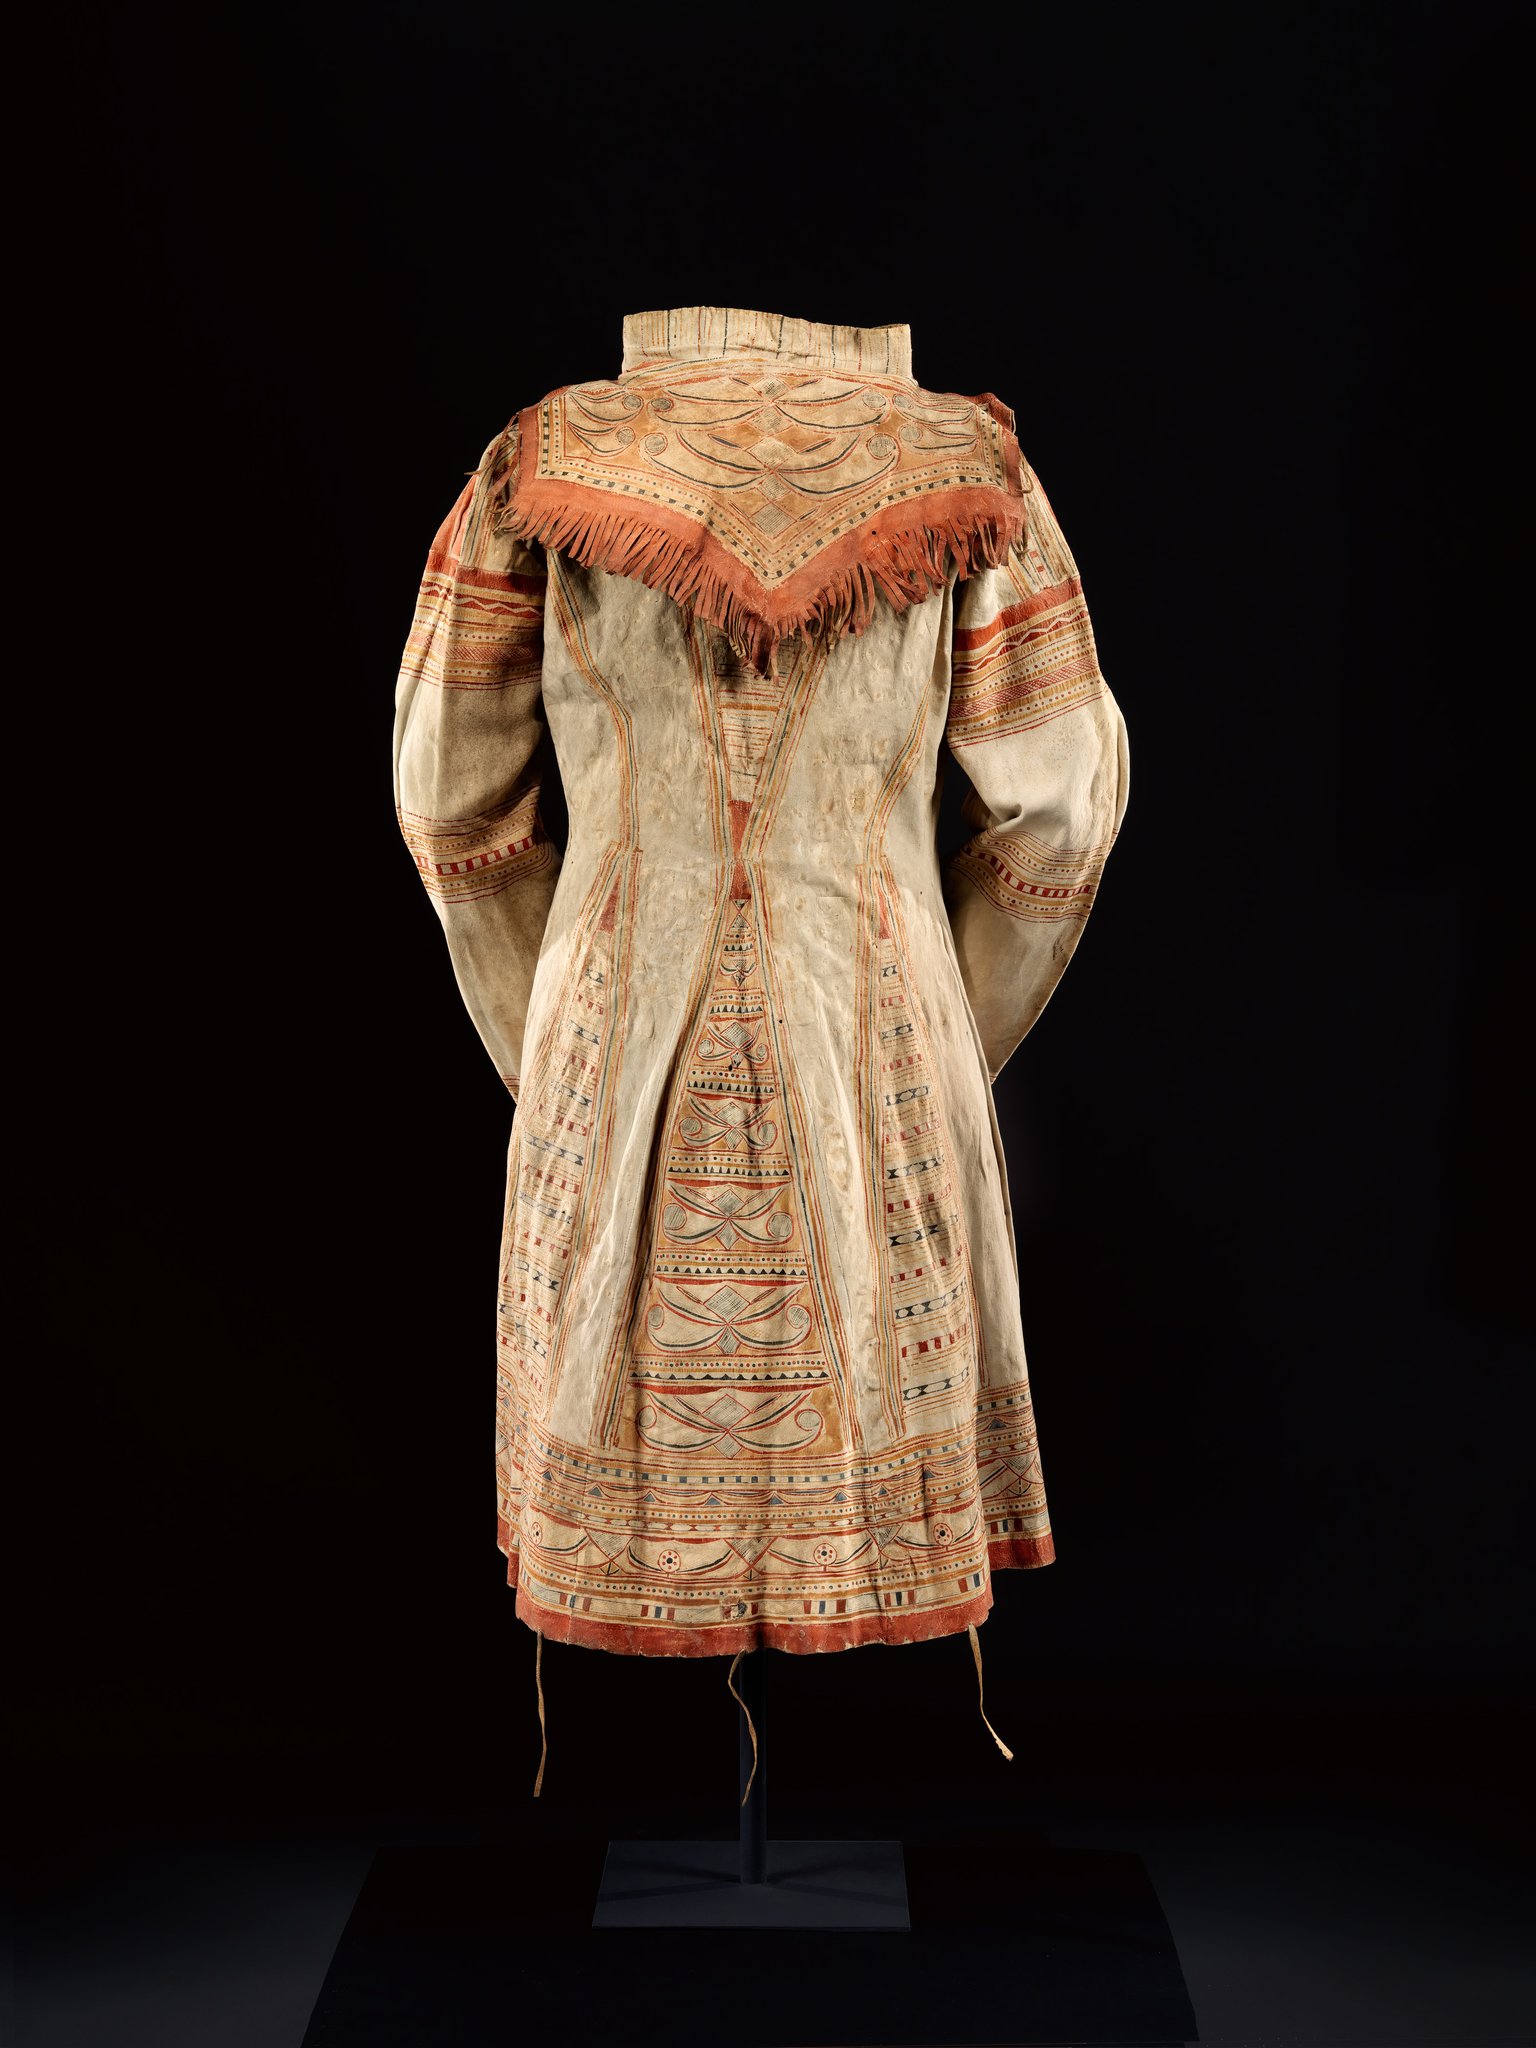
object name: coat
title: Man's coat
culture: innu or naskapi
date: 1820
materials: leather, pigment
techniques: tanning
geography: canada